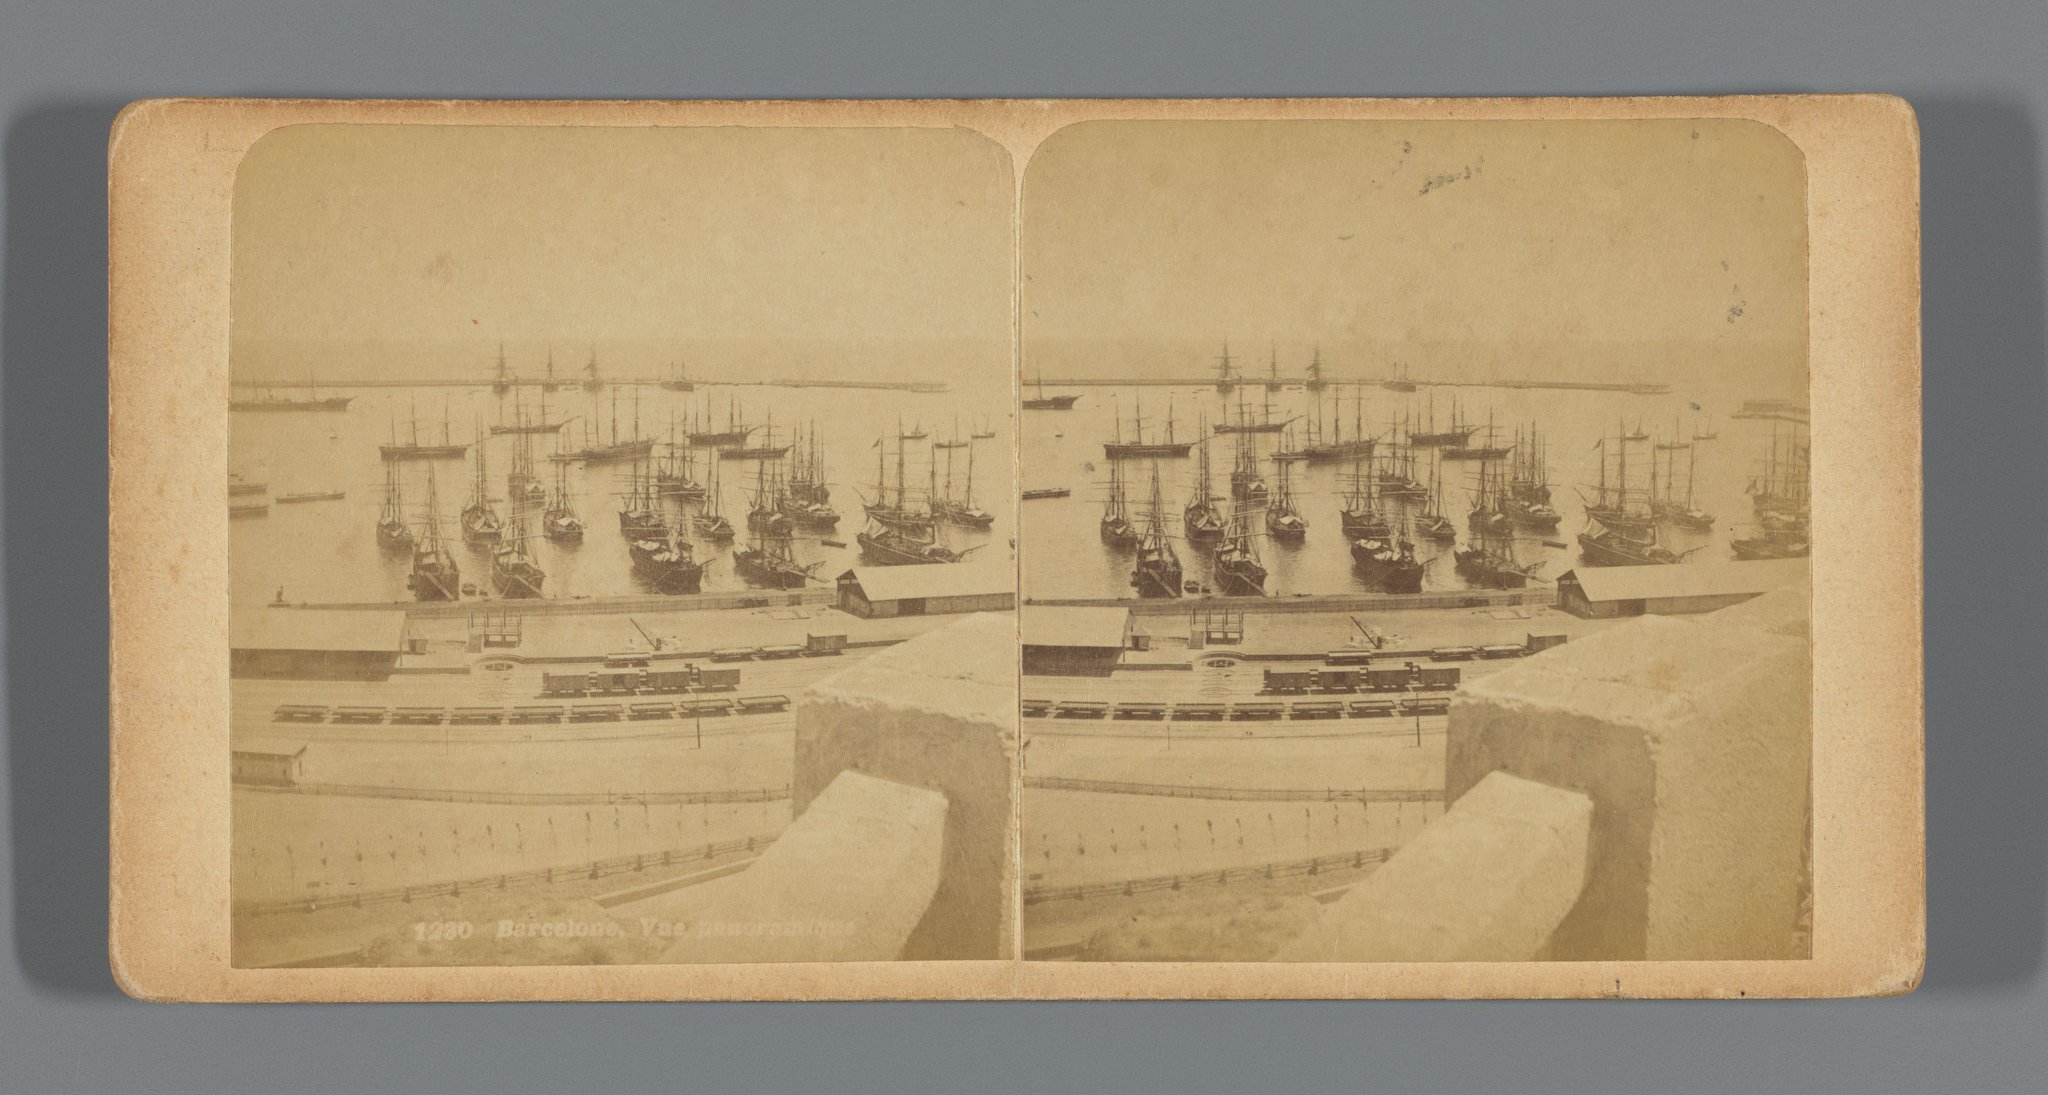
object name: stereograph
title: Aardrijkskundige Beeldengalerij, verzameld door M.J. Broekhuijsen, Hoofd eener school te Amsterdam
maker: martien johan broekhuijsen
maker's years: 1871-1956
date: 1905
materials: photographic support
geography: amsterdam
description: Onderdeel van een groep van 52 stereofoto's gebruikt in het lager onderwijs als aanvulling op schoolplaten. De gehele reeks bestond uit 274 nummers in 10 categorieën (A t/m K).